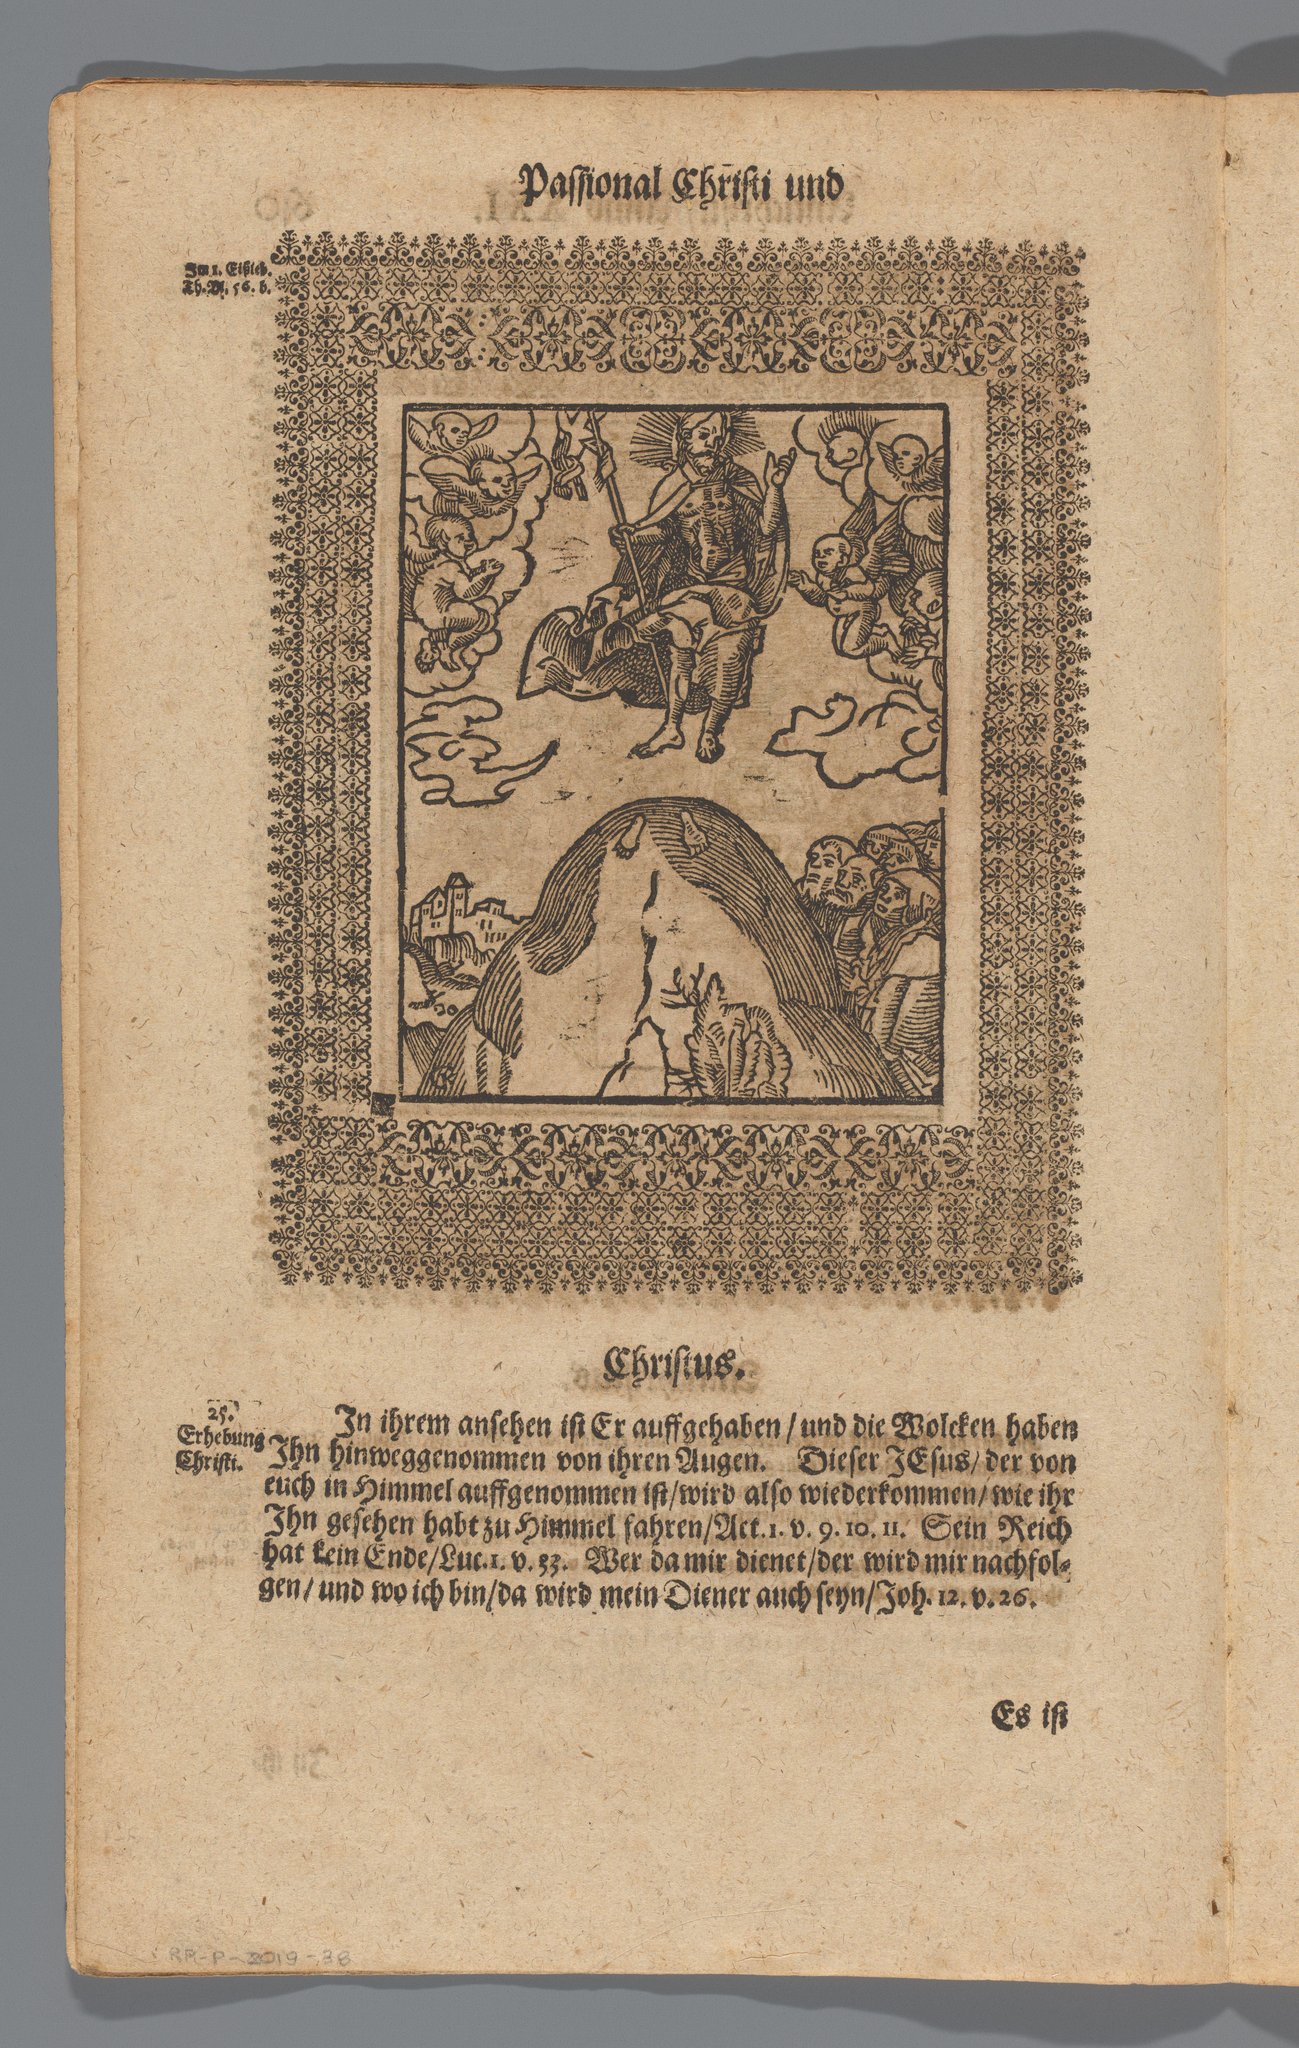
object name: print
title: Hemelvaart van Christus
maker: monogrammist gk (prentmaker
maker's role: print maker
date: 1661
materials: paper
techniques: letterpress printing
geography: europe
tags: the richness of the church opposed to christ's humility, christ ascends into heaven; apostles (and mary) beneath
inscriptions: collector's mark: Lugt 2228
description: Hemelvaart van Christus. Tegenstelling over bestemming. Spiegelbeeldige kopie naar de prent van Lucas Cranach in het pamflet 'Passional Christi und Antichristi' van Martin Luther uit 1521, bladzijde uit een 17e-eeuwse uitgave. De reeks van dertien paar houtsneden geeft de tegenstellingen weer tussen de nederigheid en onbaatzuchtigheid van Christus enerzijds, en de trots en hebzucht van de paus anderzijds.